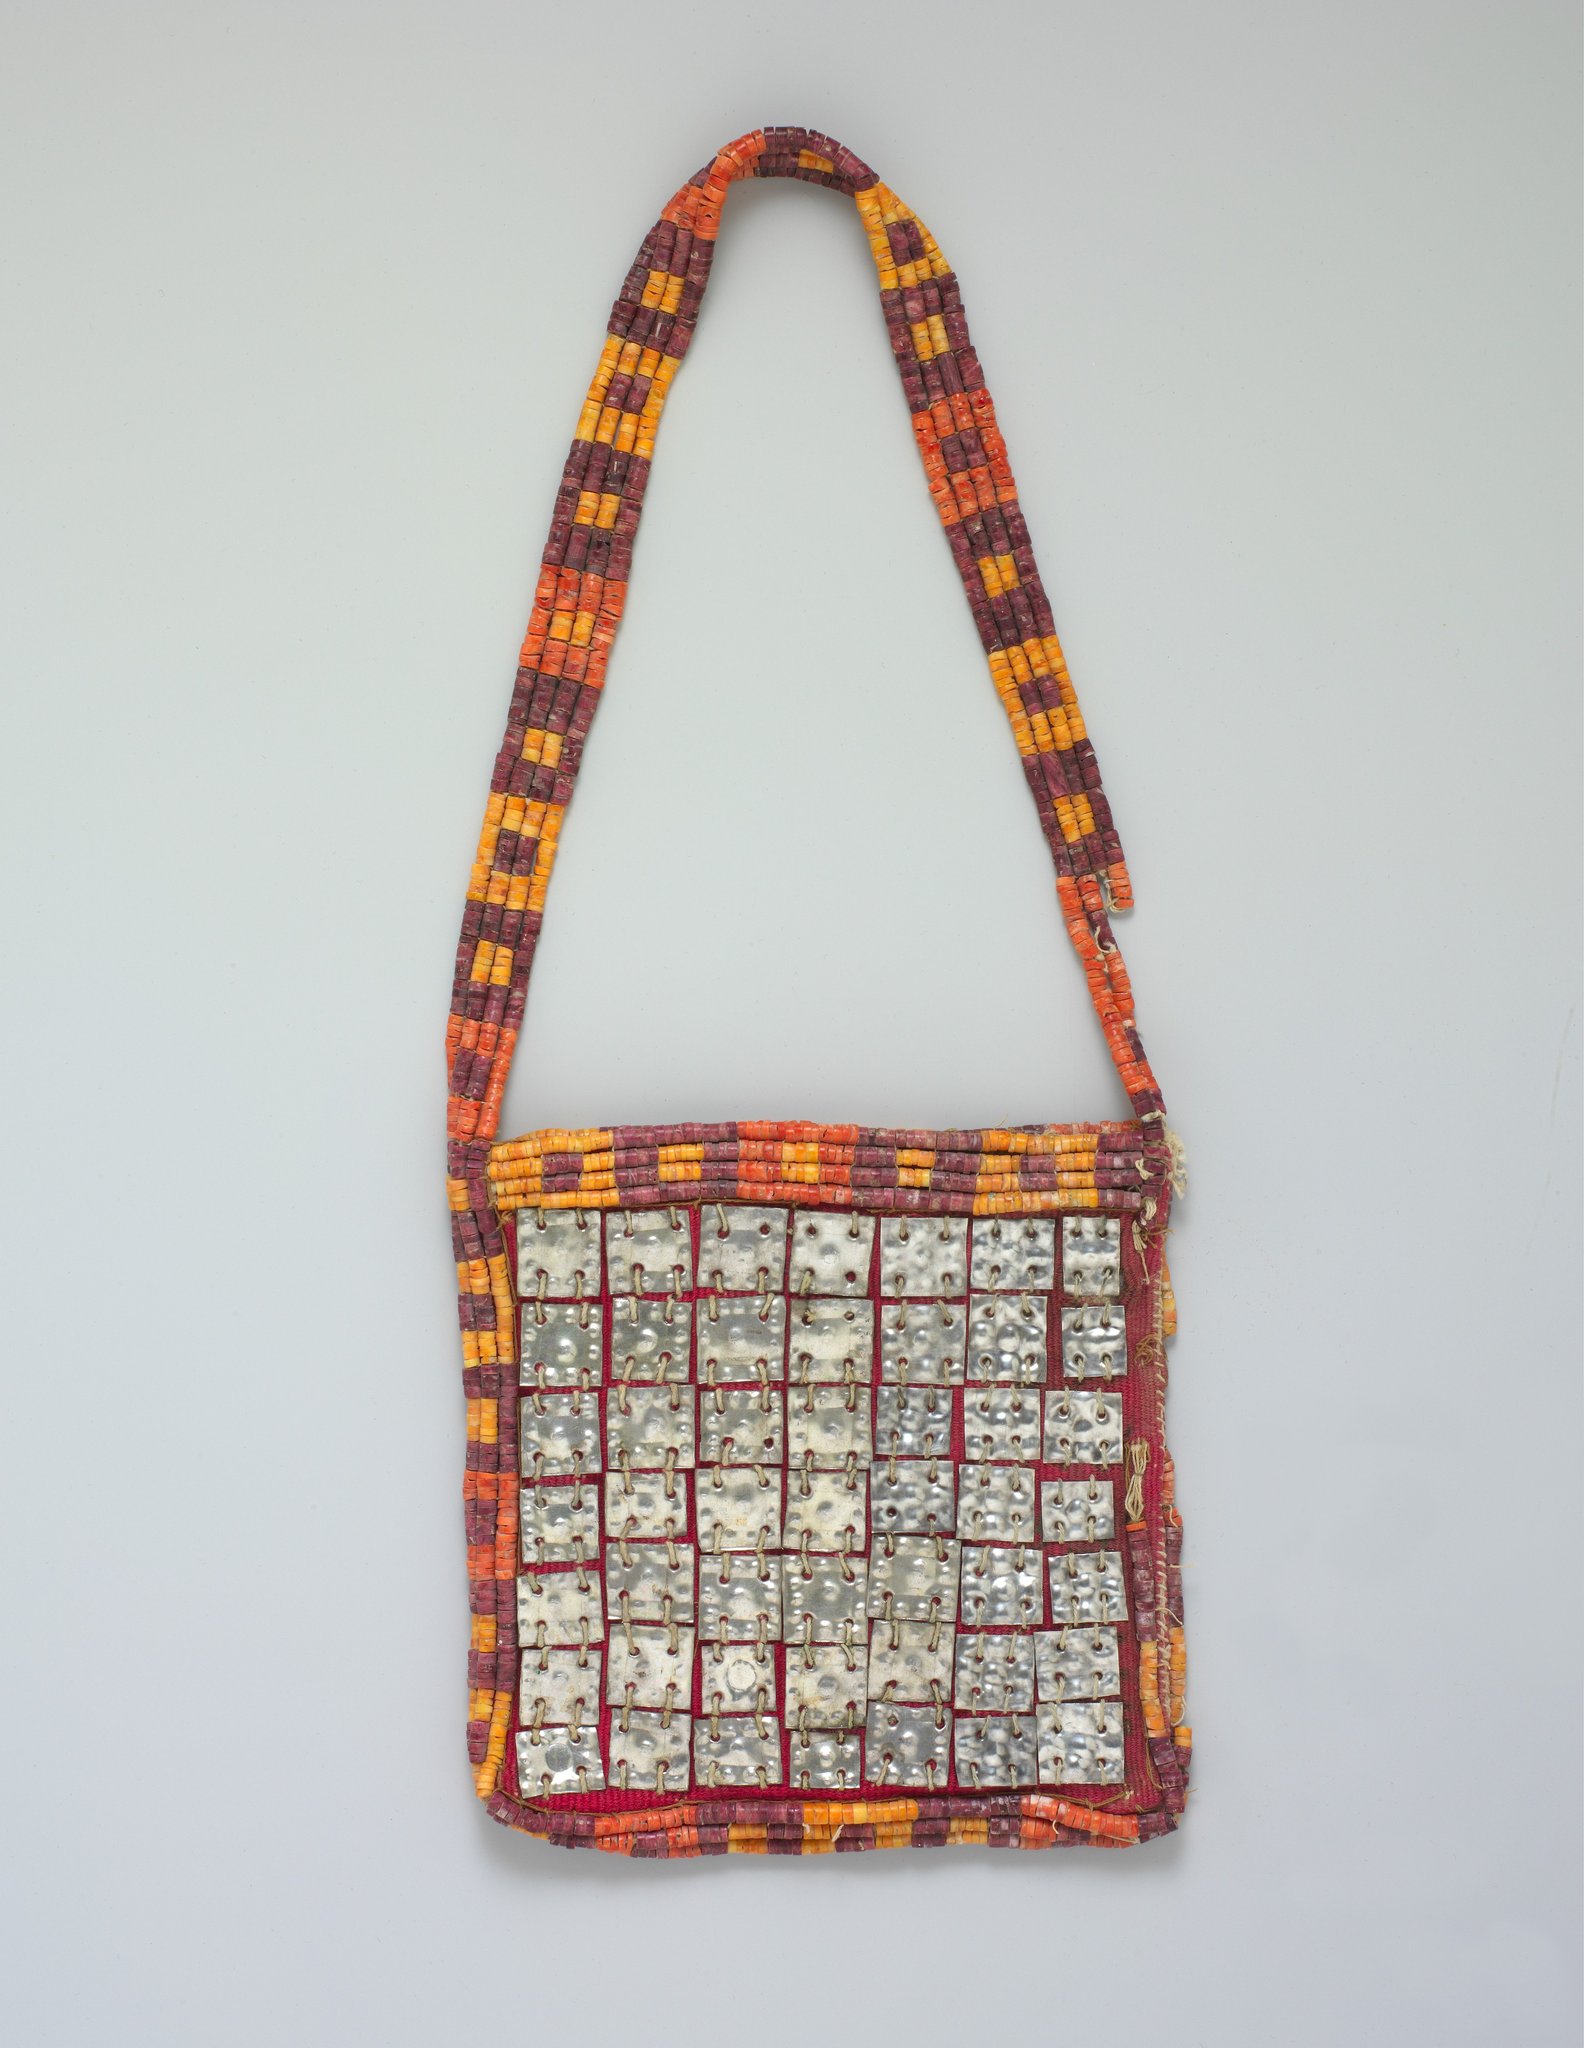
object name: bag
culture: chimú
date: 1301-1500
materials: animal fiber, cotton, shell, silver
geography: peru